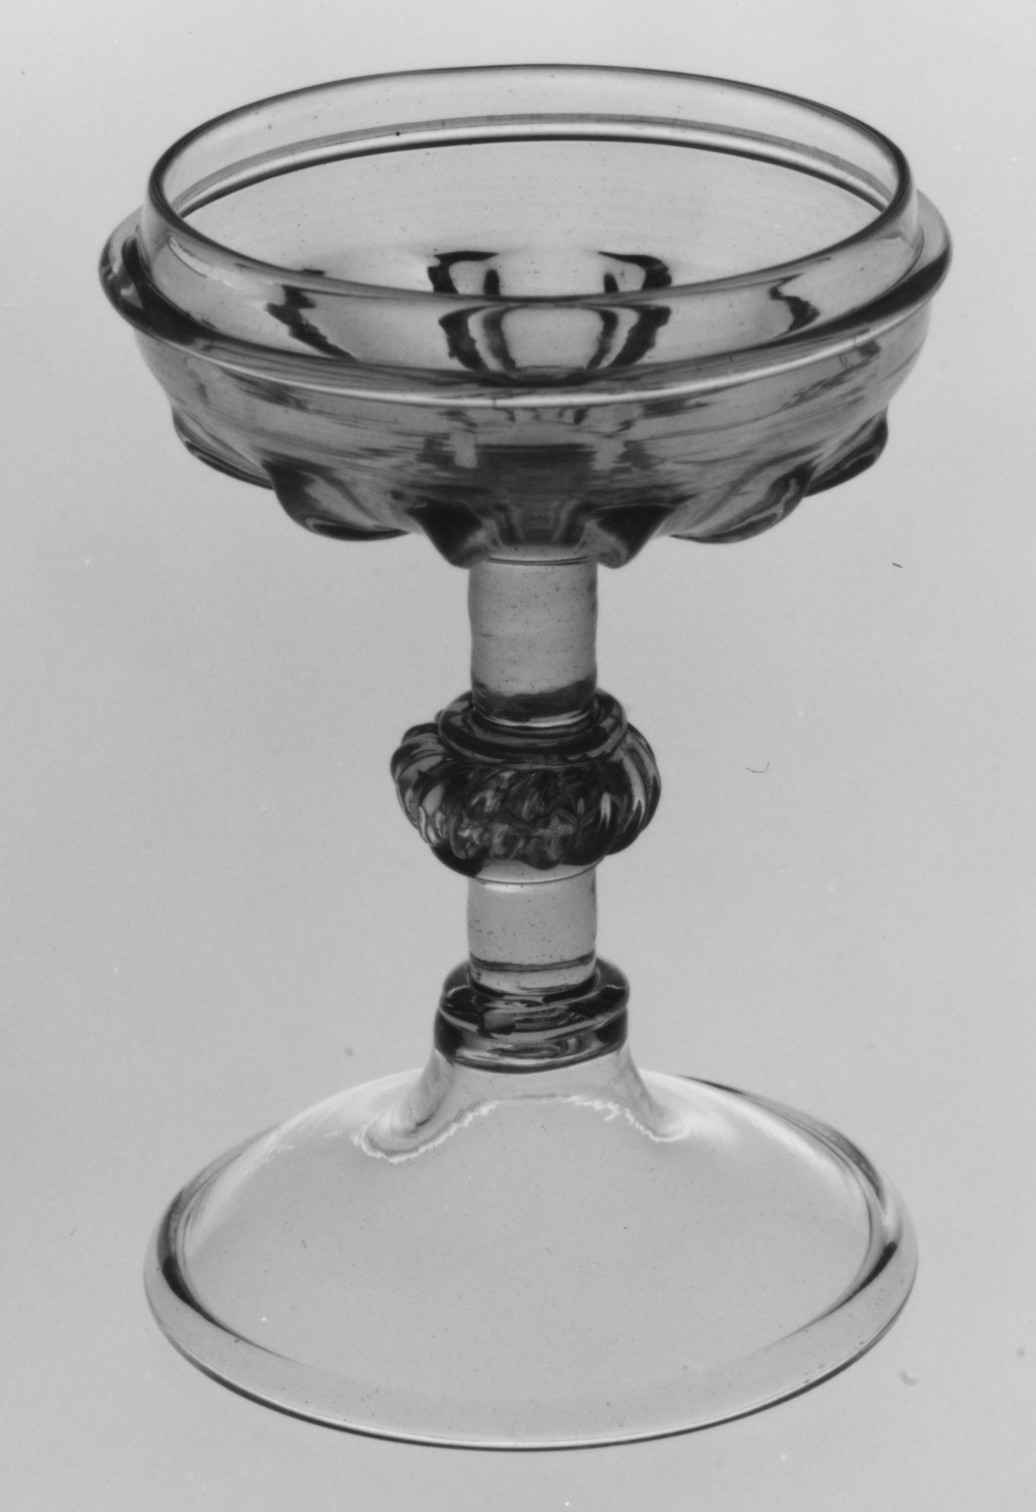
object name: cup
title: Stemmed cup (?)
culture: italian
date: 1501-1600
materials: gilt, glass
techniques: glassblowing, molding